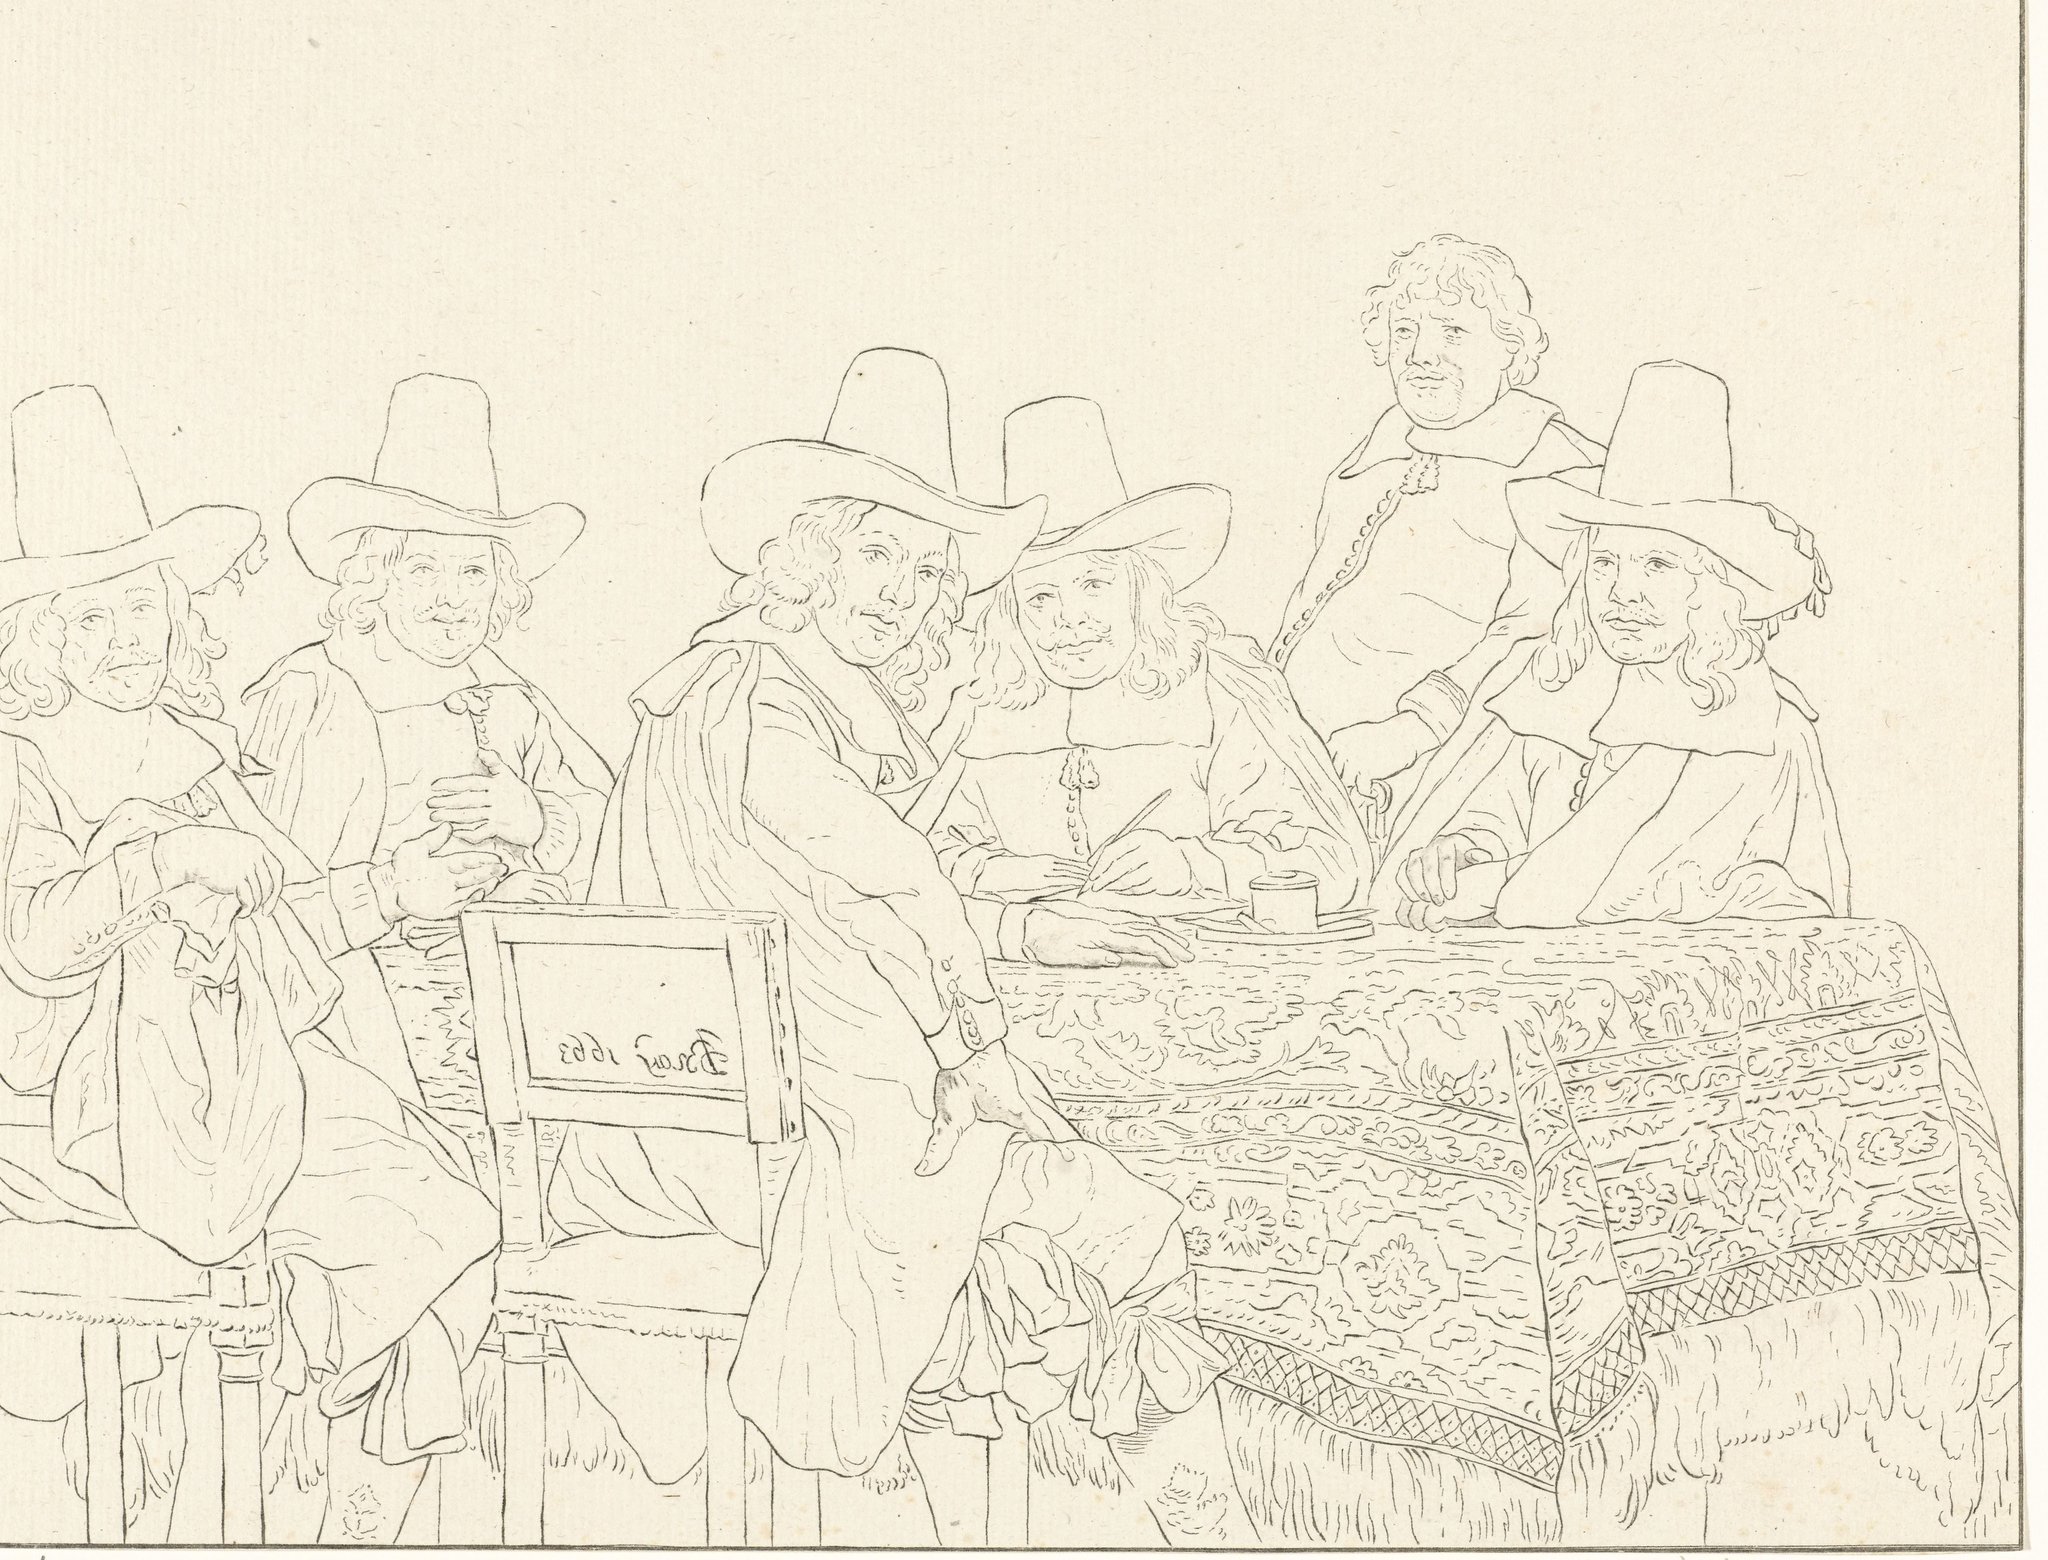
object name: print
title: Regenten van het weeshuis te Haarlem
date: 1777-1786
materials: paper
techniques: printmaking, etching, roulette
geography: amsterdam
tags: table, board, esp. governors, trustees, etc. (dutch: 'regenten')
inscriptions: collector's mark: Lugt 240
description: De regenten van het weeshuis van Haarlem bijeen om een tafel. De bode staat op de achtergrond.